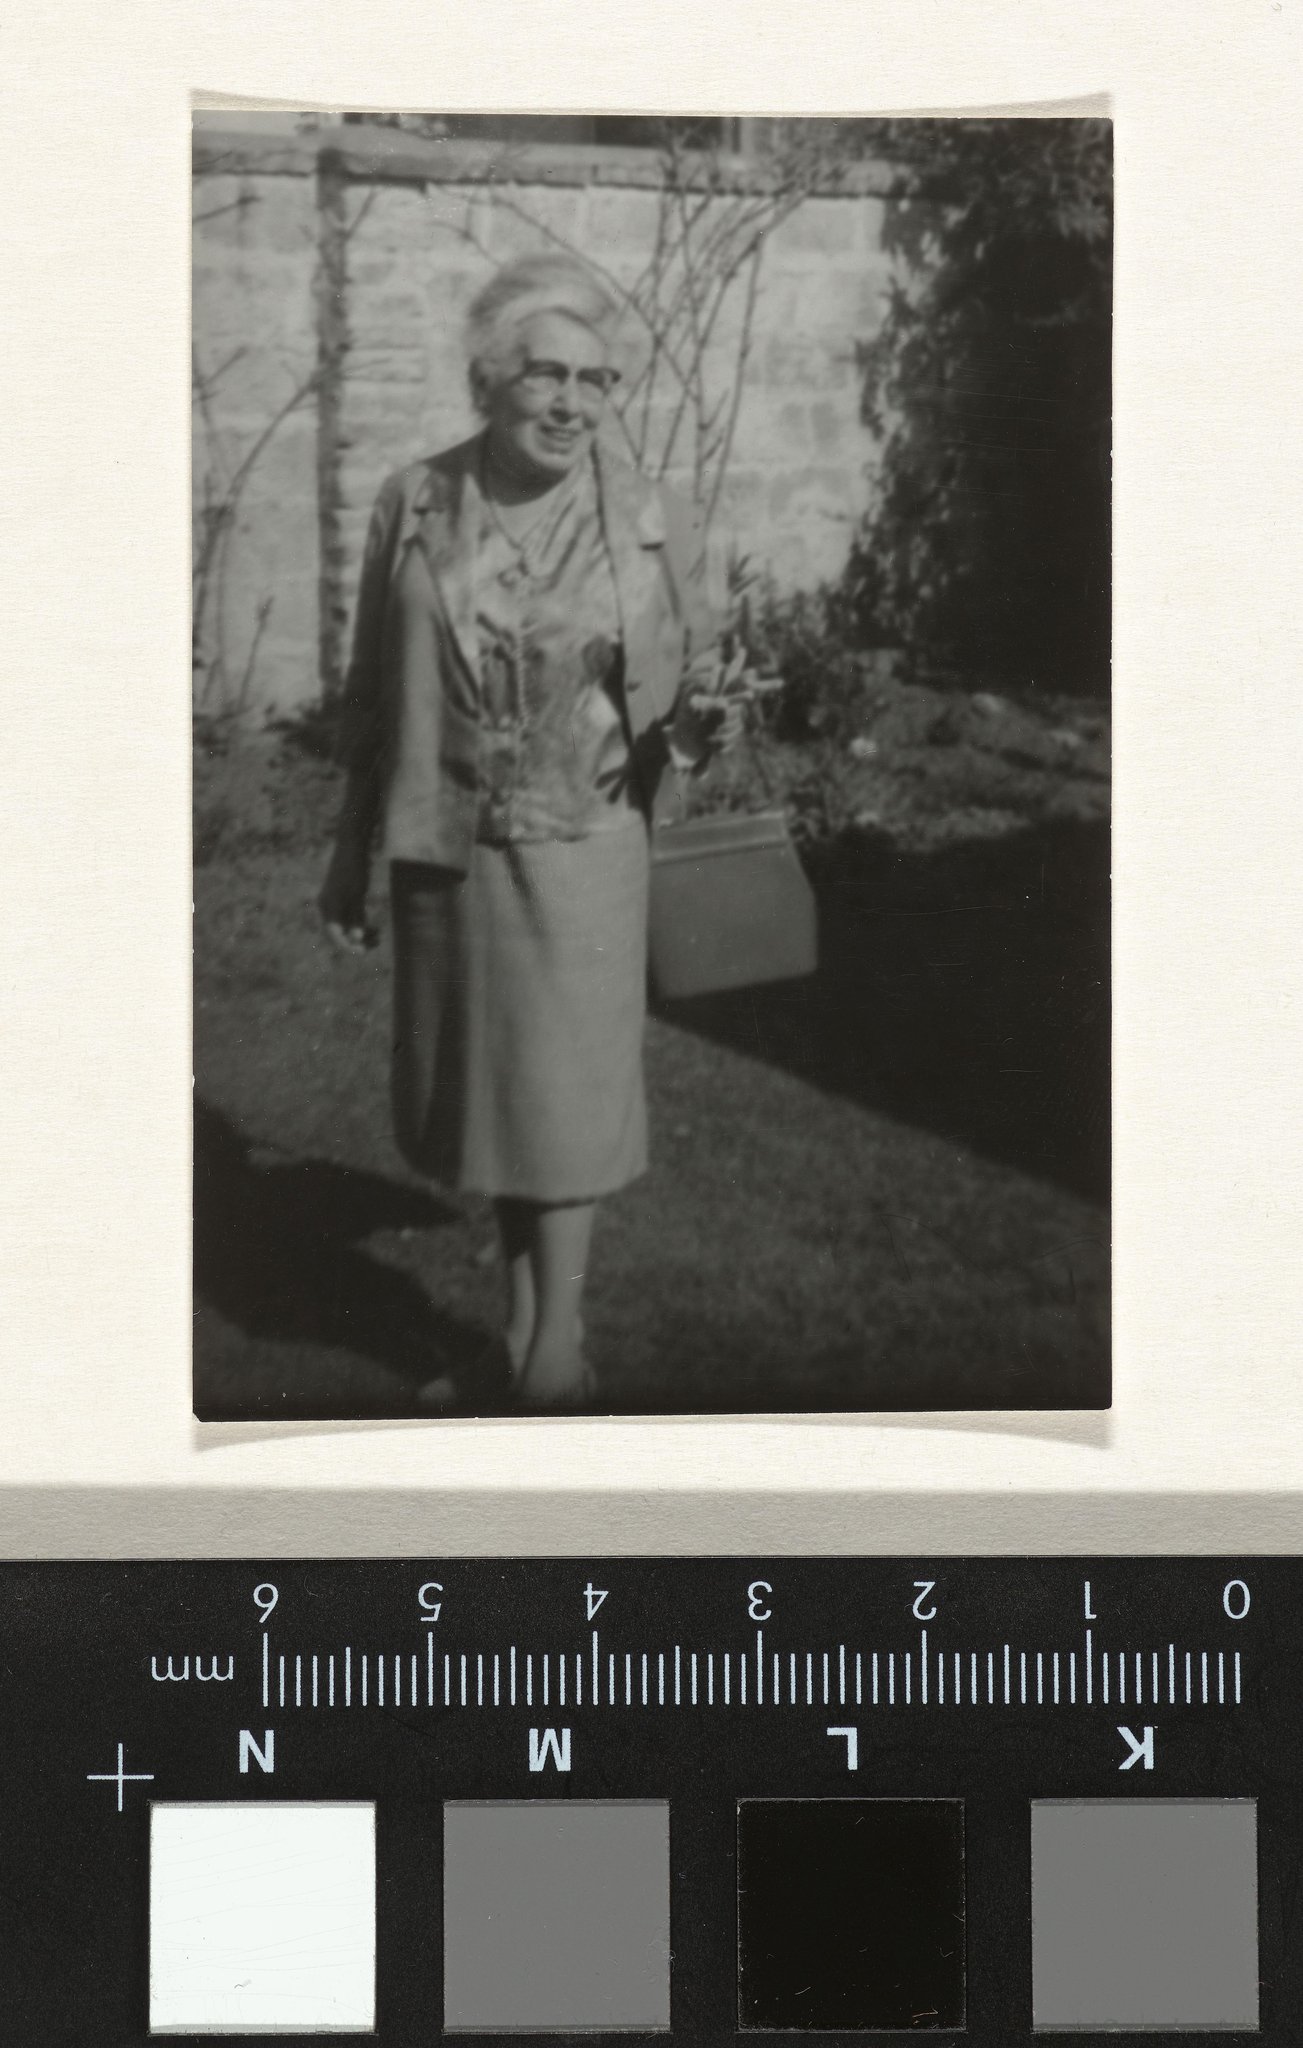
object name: photograph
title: Oudere vrouw in een tuin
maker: Anonymous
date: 1950-1970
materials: paper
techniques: gelatin silver print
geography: germany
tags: garden, old woman, germany